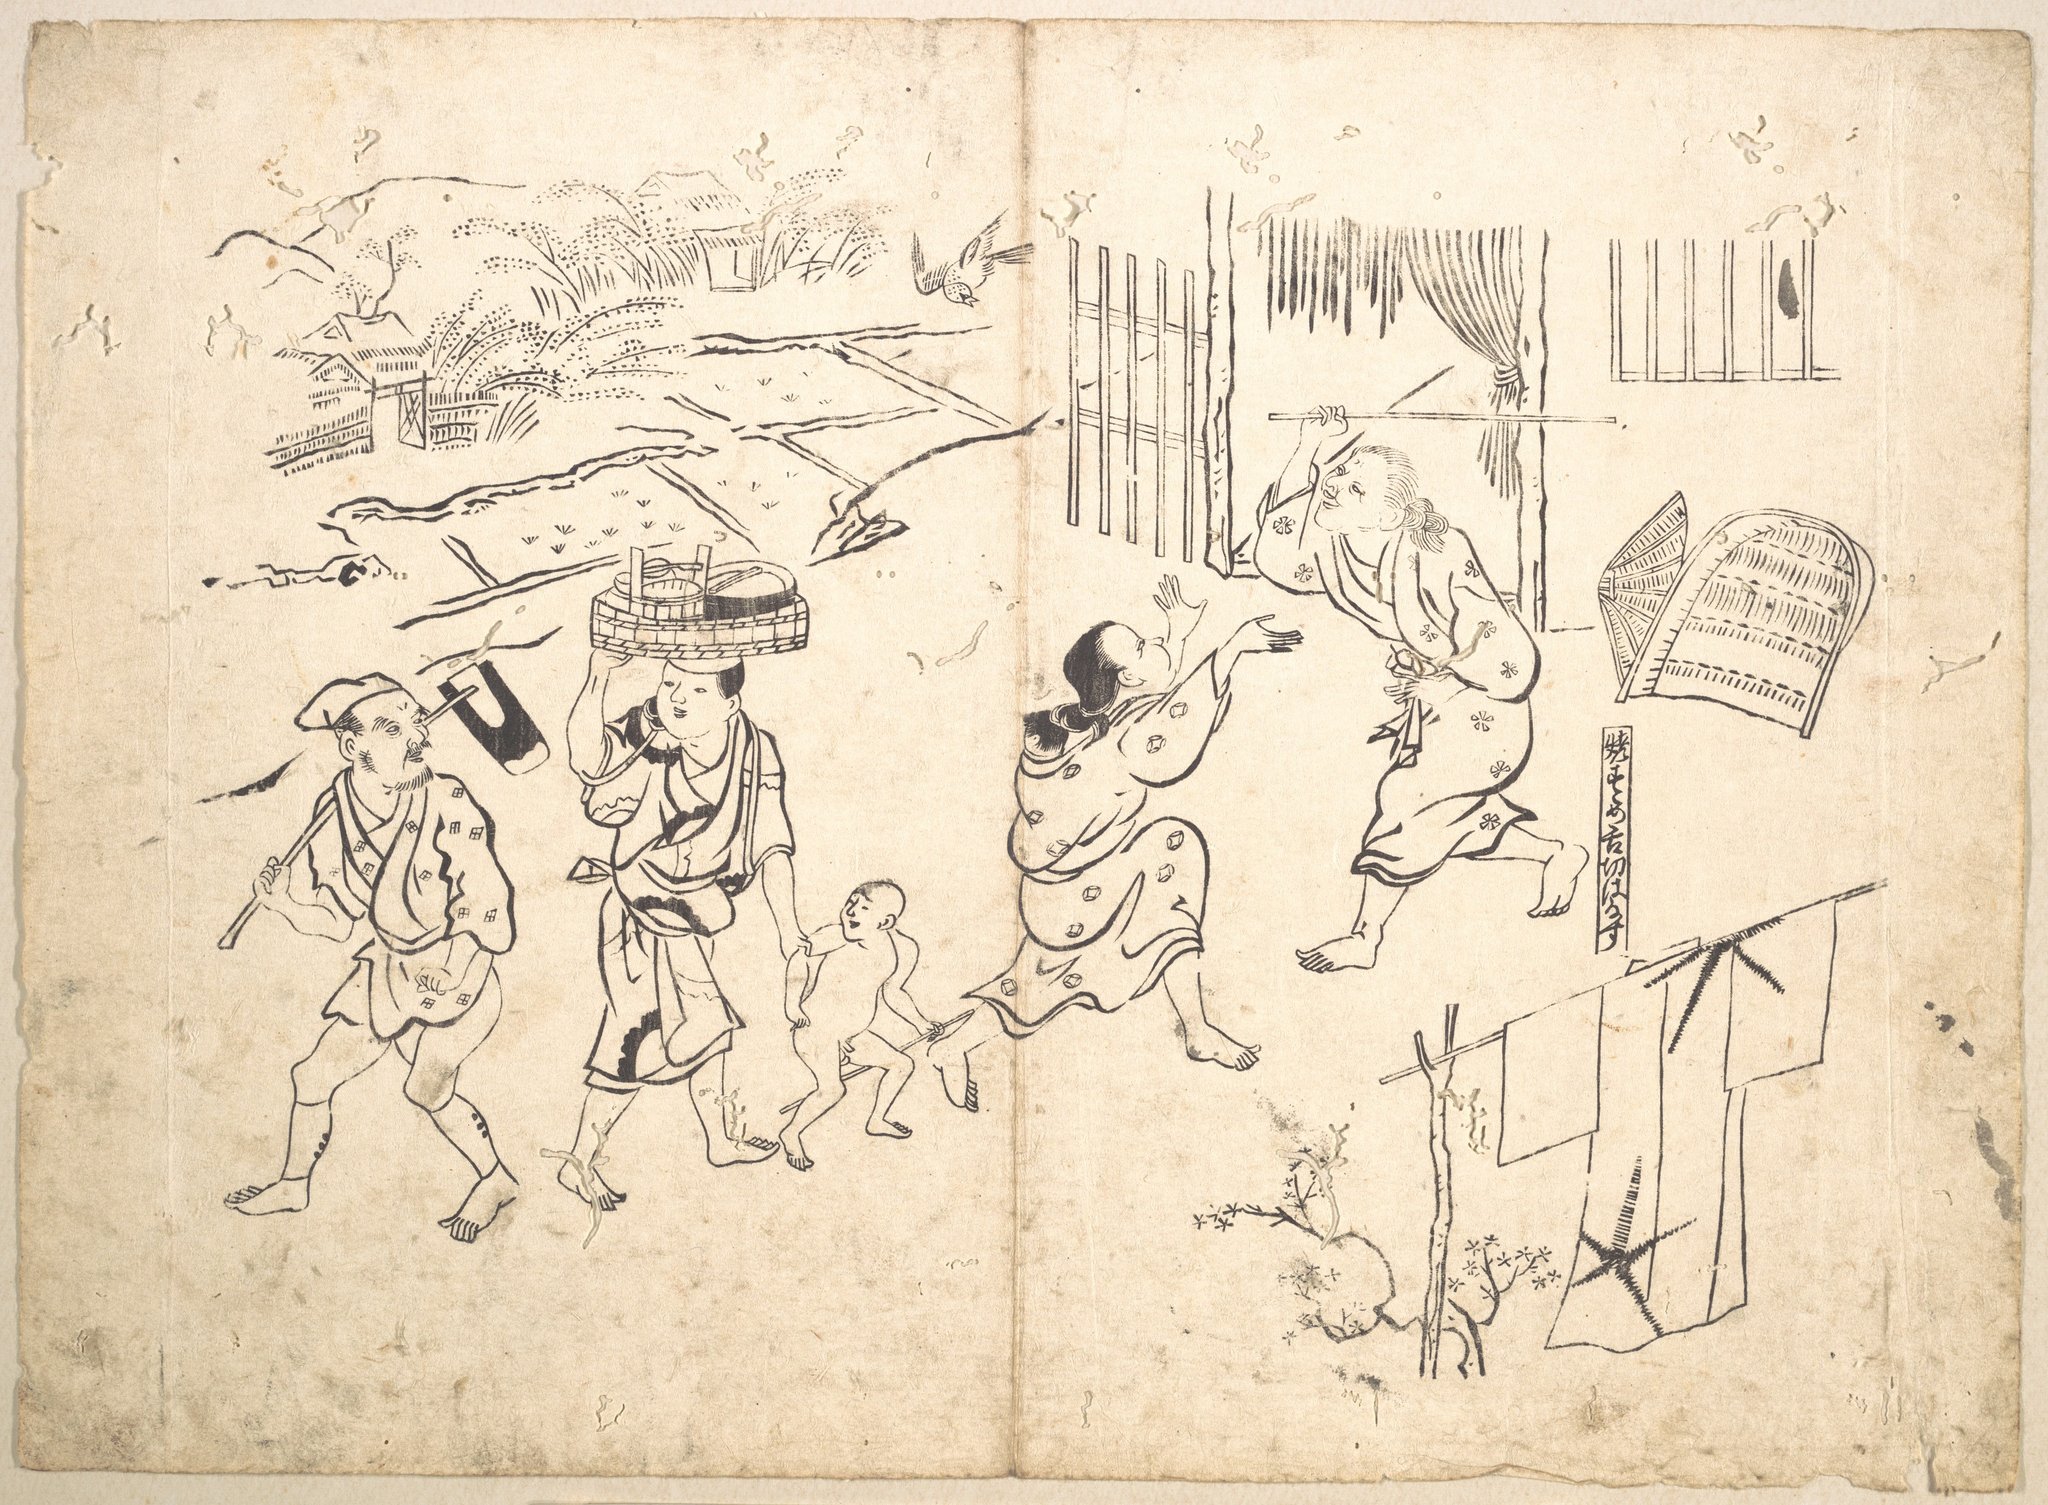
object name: print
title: Woman Pursuing Sparrow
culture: japanese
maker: okumura masanobu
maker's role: artist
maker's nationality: japanese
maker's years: 1686-1764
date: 1691-1768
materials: ink, paper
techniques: woodblock print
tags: birds,children,men,women